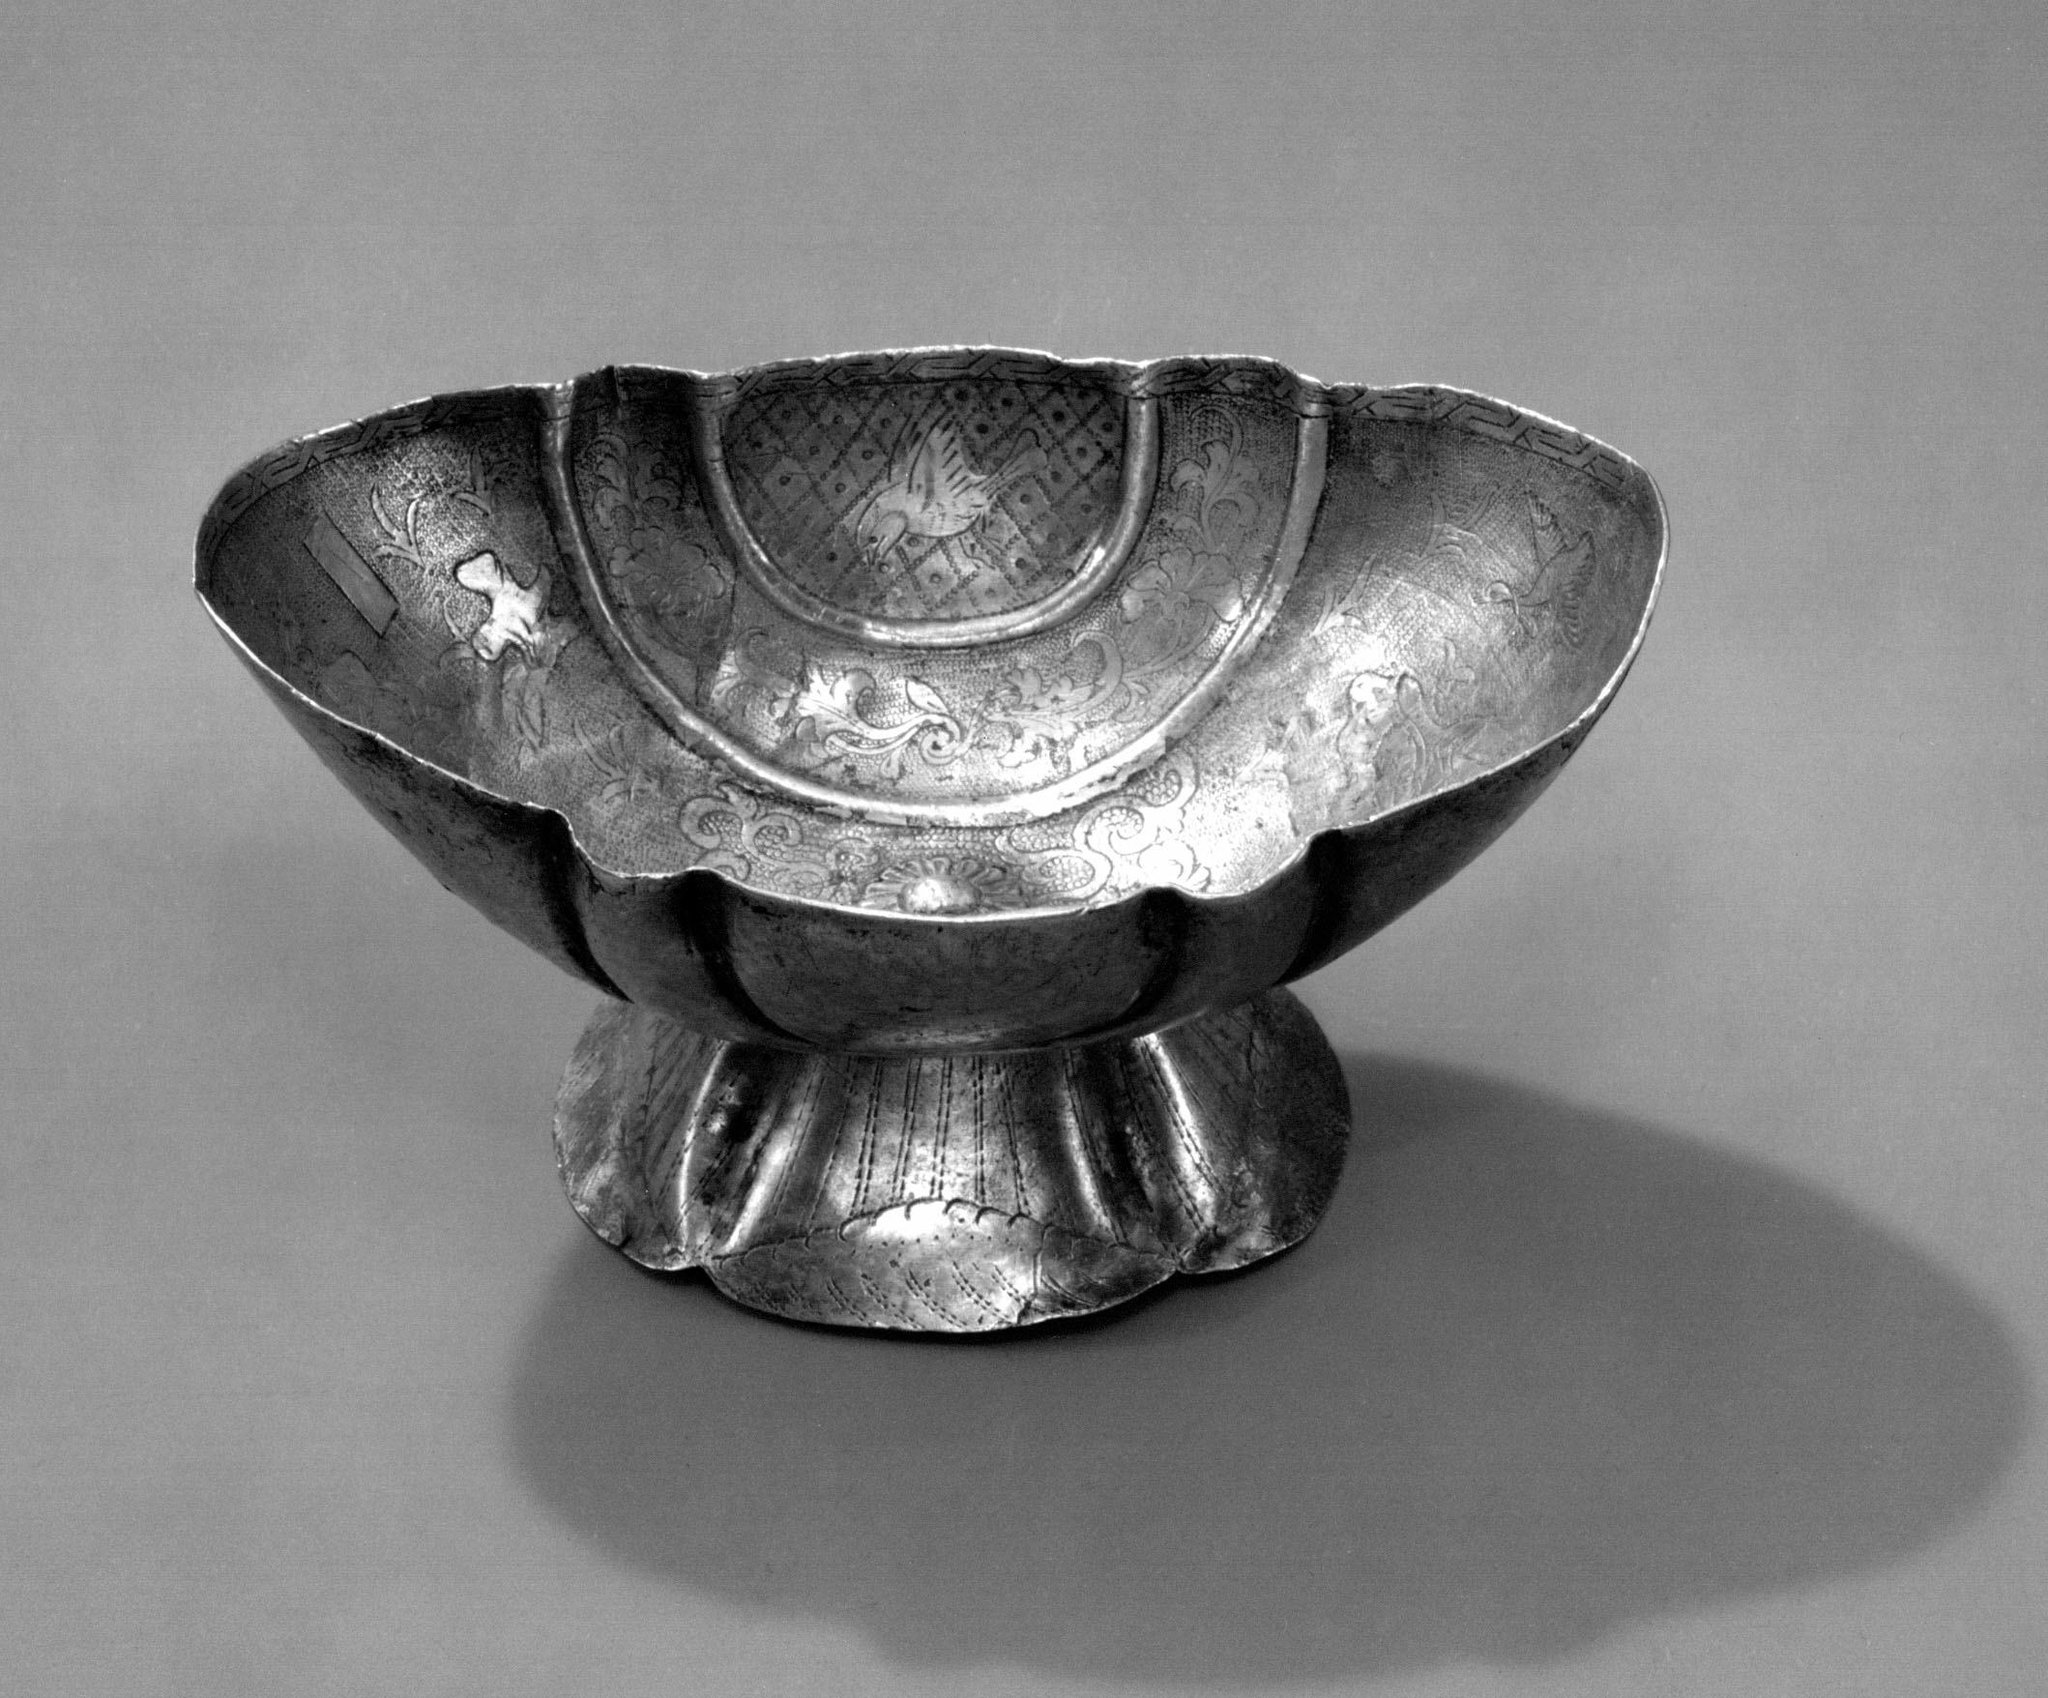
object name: cup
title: Cup with figures in a landscape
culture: chinese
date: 801-900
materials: silver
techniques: gilding